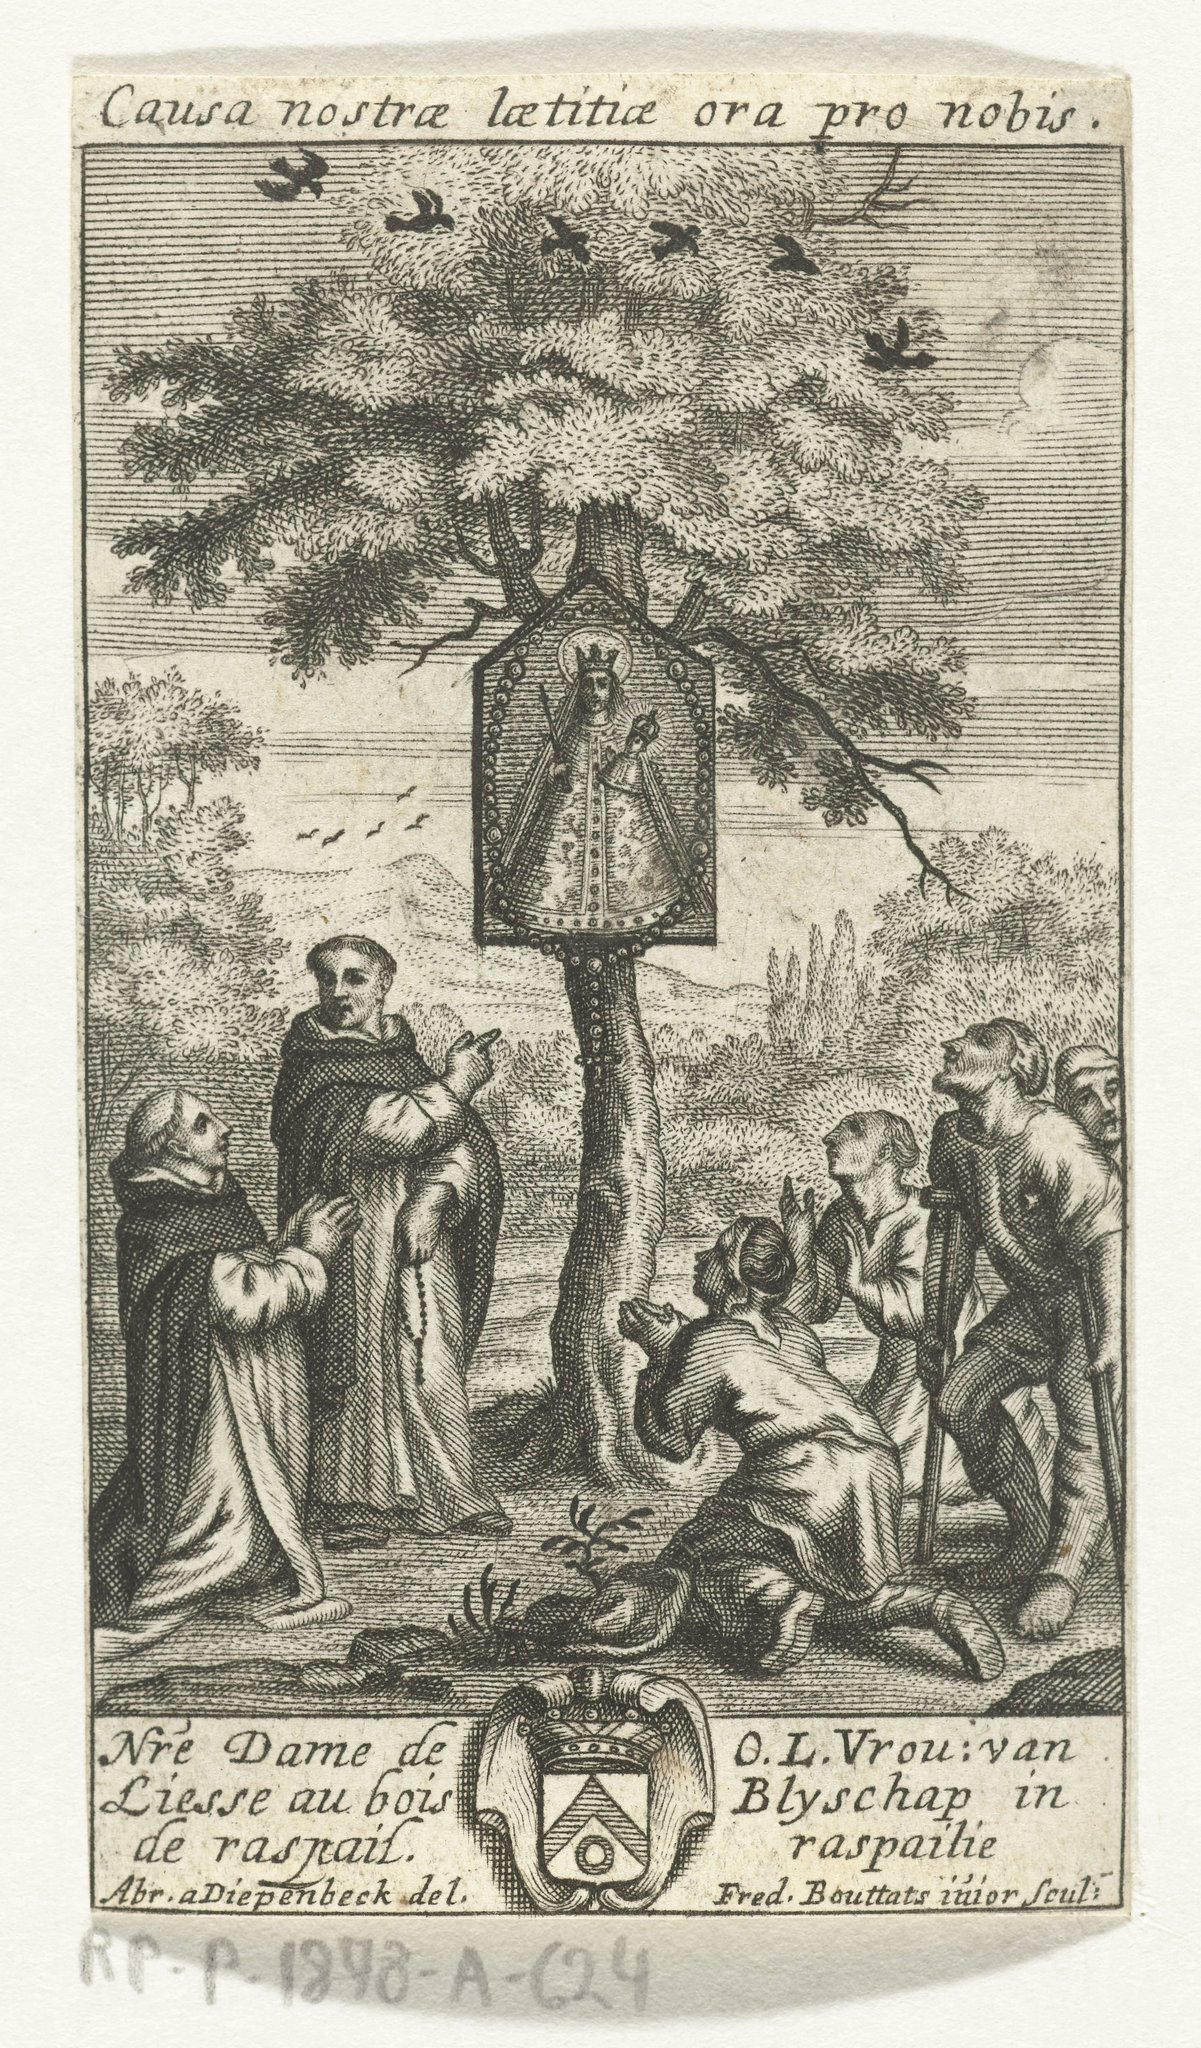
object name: print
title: Onze-Lieve-Vrouw van Blijschap van het Raspaillebos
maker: frederik bouttats (de jonge)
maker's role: print maker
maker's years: 1610-1676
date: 1620-1676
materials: paper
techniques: engraving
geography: antwerp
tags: mary devotion, monastic orders, monastic life ~ roman catholic church (with name of order), road side shrine, the poor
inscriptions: collector's mark: Lugt 2228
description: Een wegkapel in Raspaillebos (Geraardsbergen), gewijd aan Onze-Lieve-Vrouwe van Blijschap (of Onze-Lieve-Vrouwe van Vreugde). In het midden van de prent een boom met een afbeelding van de Maagd Maria. Links van de boom twee Dominicanen. Rechts van de boom een groep knielende en biddende armen. De prent heeft een Nederlands en Frans onderschrift.